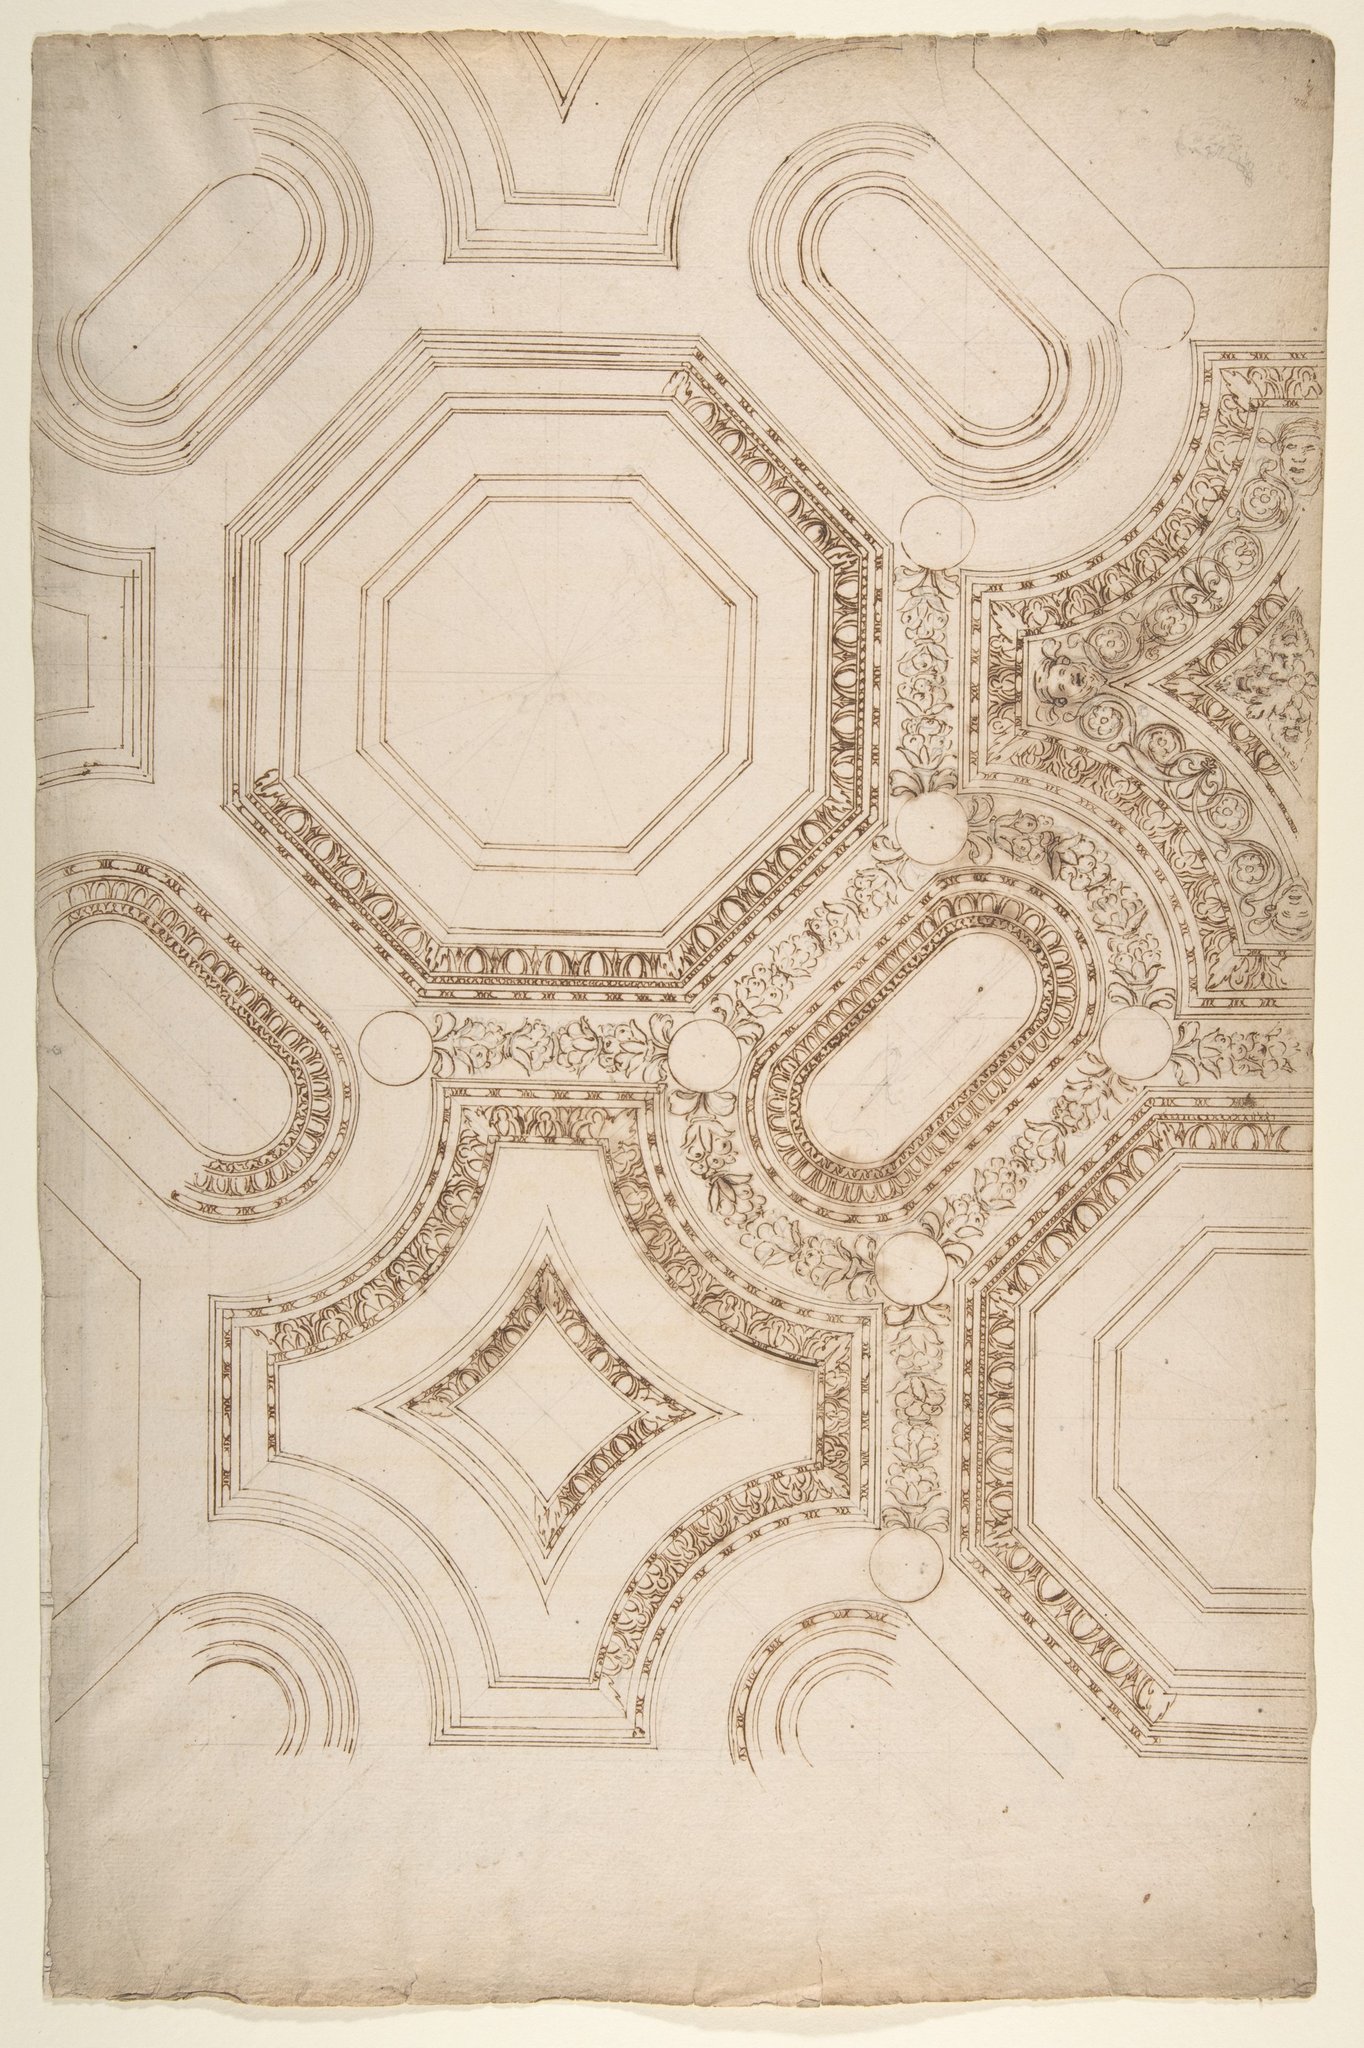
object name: drawing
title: Palazzo Pontifici, Sala Regia, coffer panels, reflected ceiling plan (recto) blank (verso)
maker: anonymous, french, 16th century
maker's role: draftsman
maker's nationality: french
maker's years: 1500-1600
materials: chalk, ink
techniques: incising